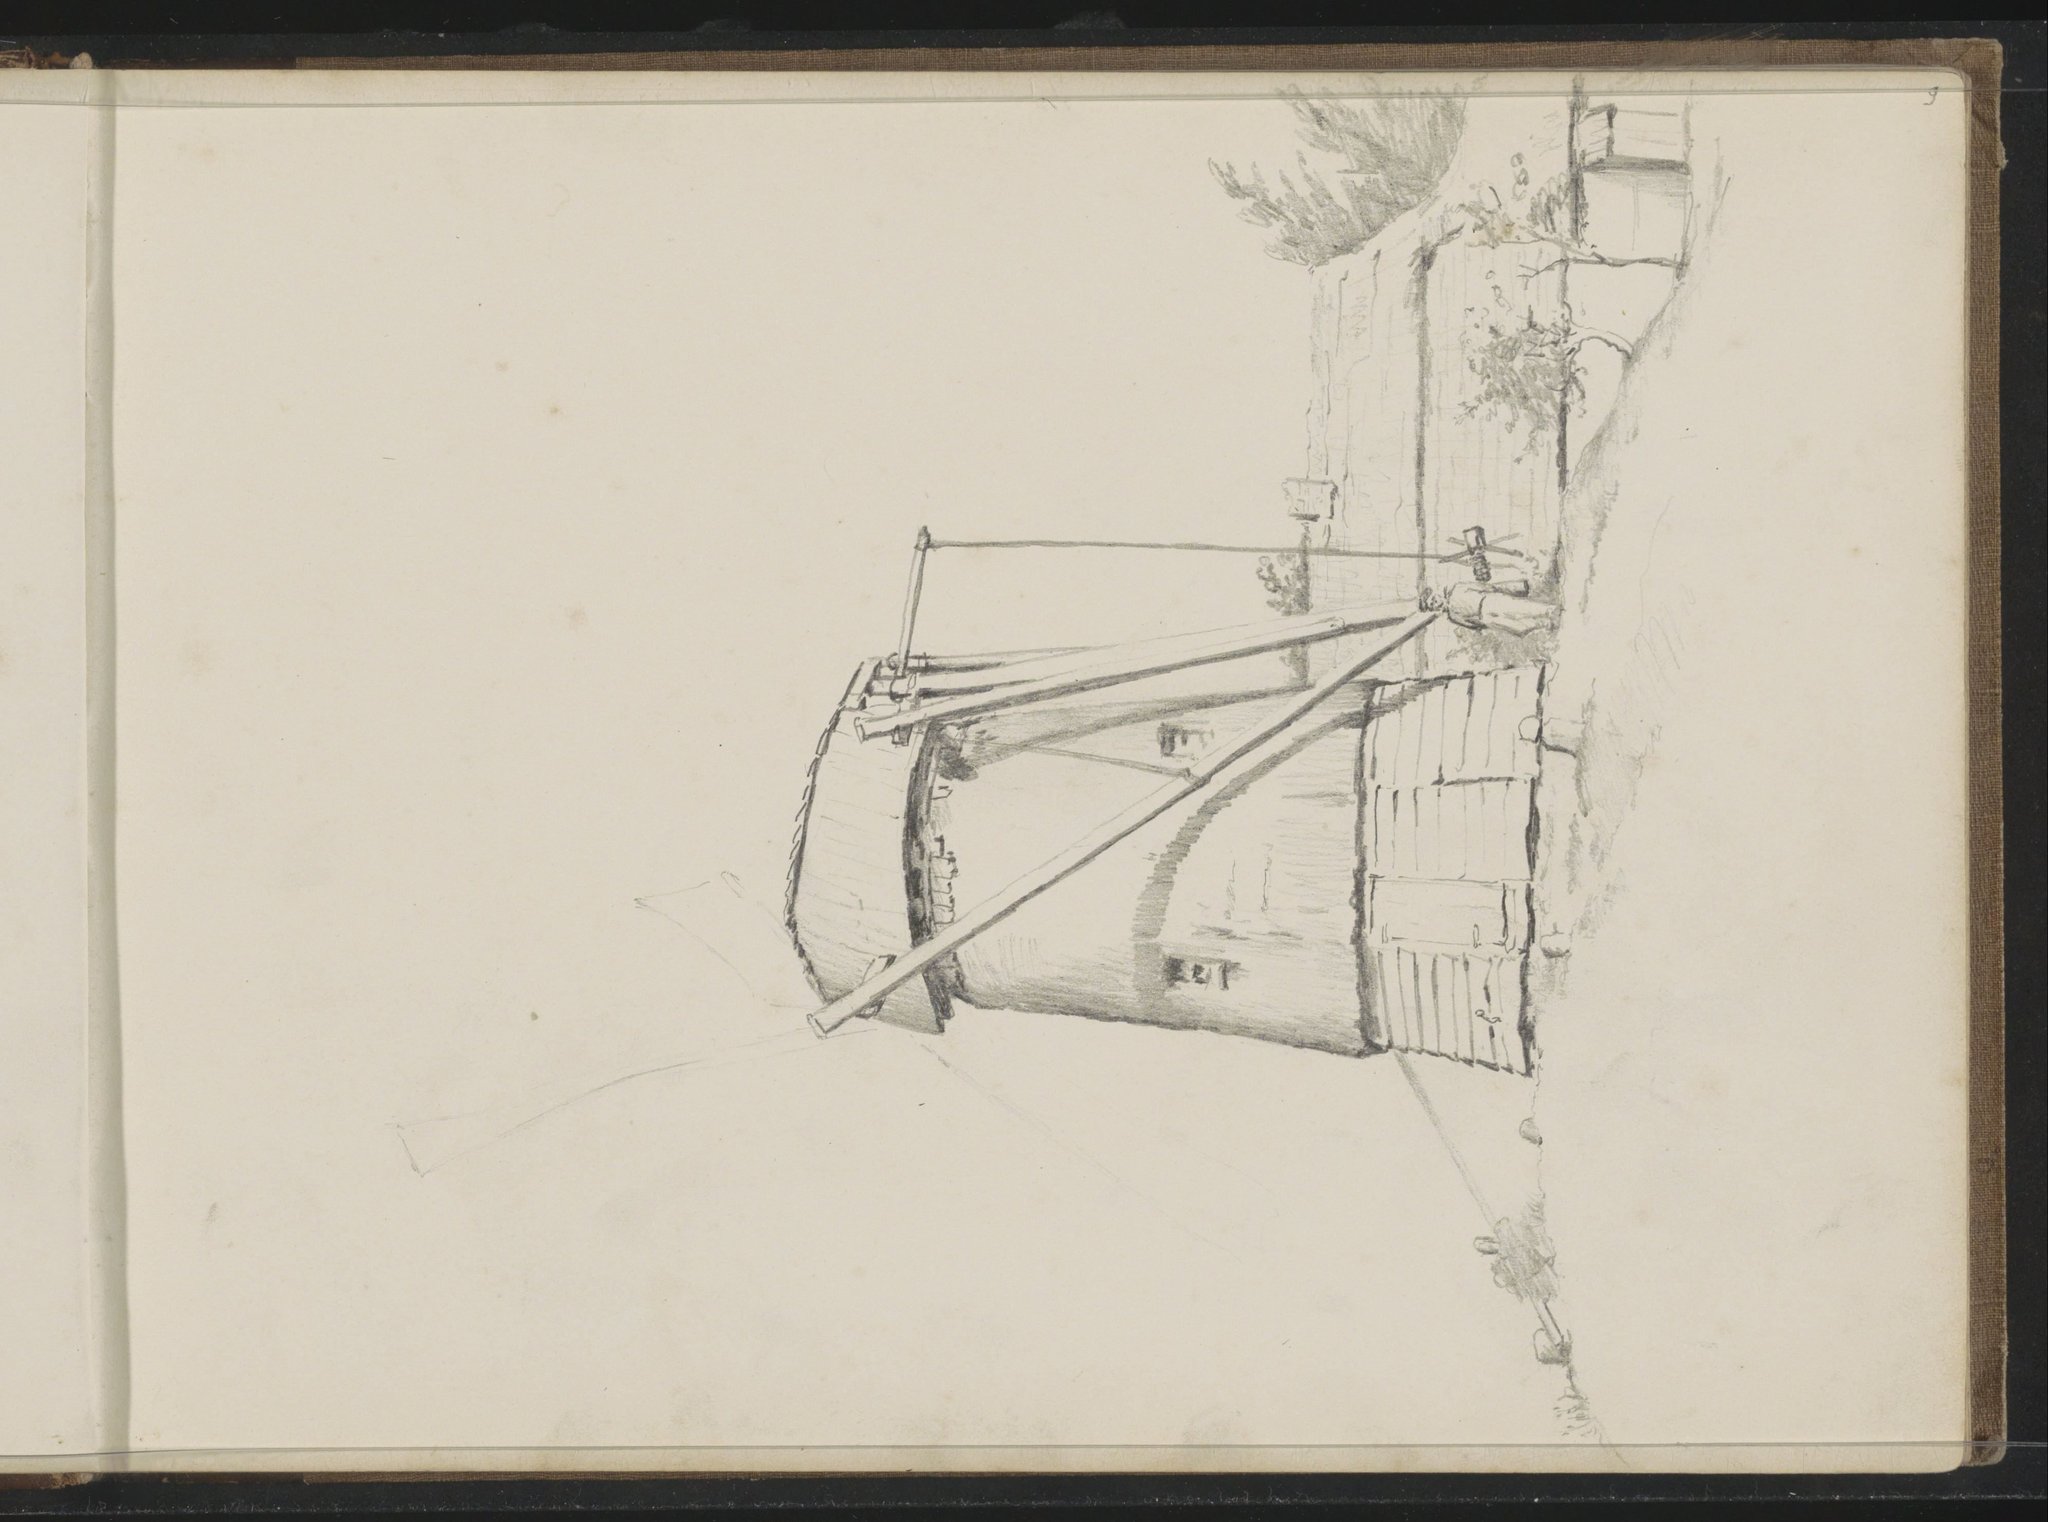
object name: sketchbook leaf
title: Man bij een molen op een heuvel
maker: hendrik valkenburg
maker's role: draughtsman, painter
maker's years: 1826-1896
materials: paper, pencil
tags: low hill country, windmill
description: Blad 9 recto uit een schetsboek met 77 bladen.